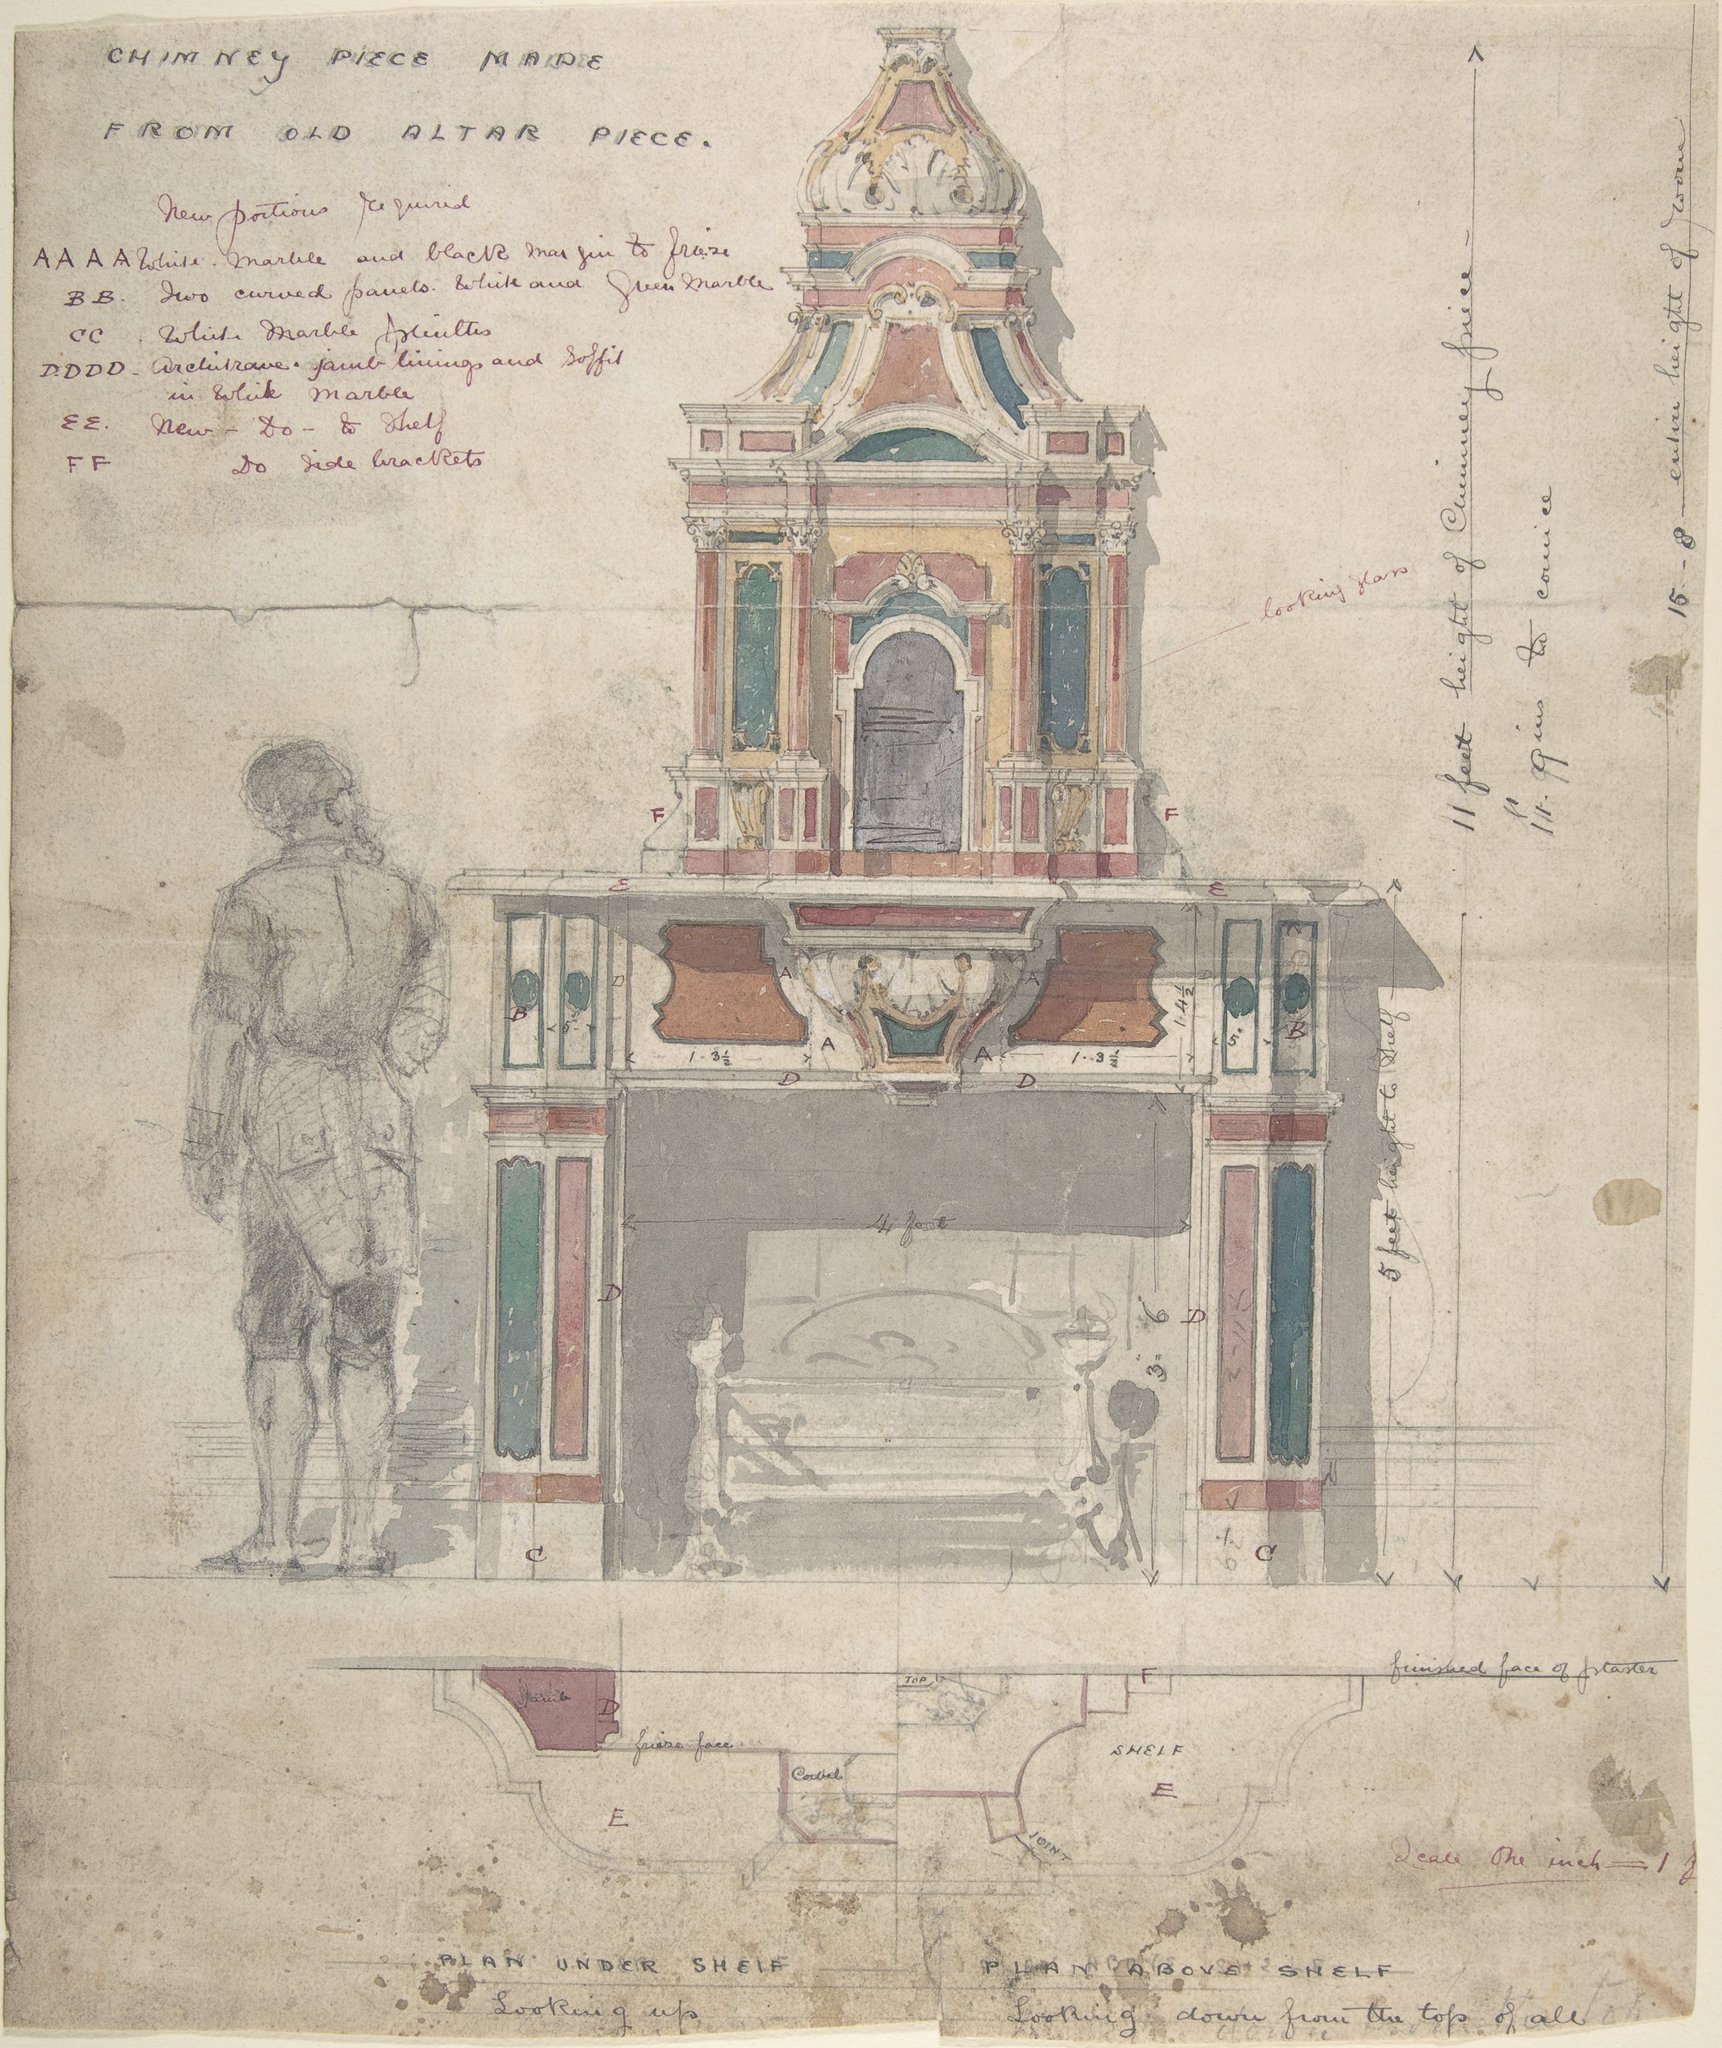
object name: drawing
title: Design for a Chimneypiece Made from an Old Altarpiece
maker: anonymous, british, 19th century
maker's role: artist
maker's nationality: british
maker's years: 1800-1900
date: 1801-1900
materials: ink, watercolor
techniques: pen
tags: altars,fireplaces,men